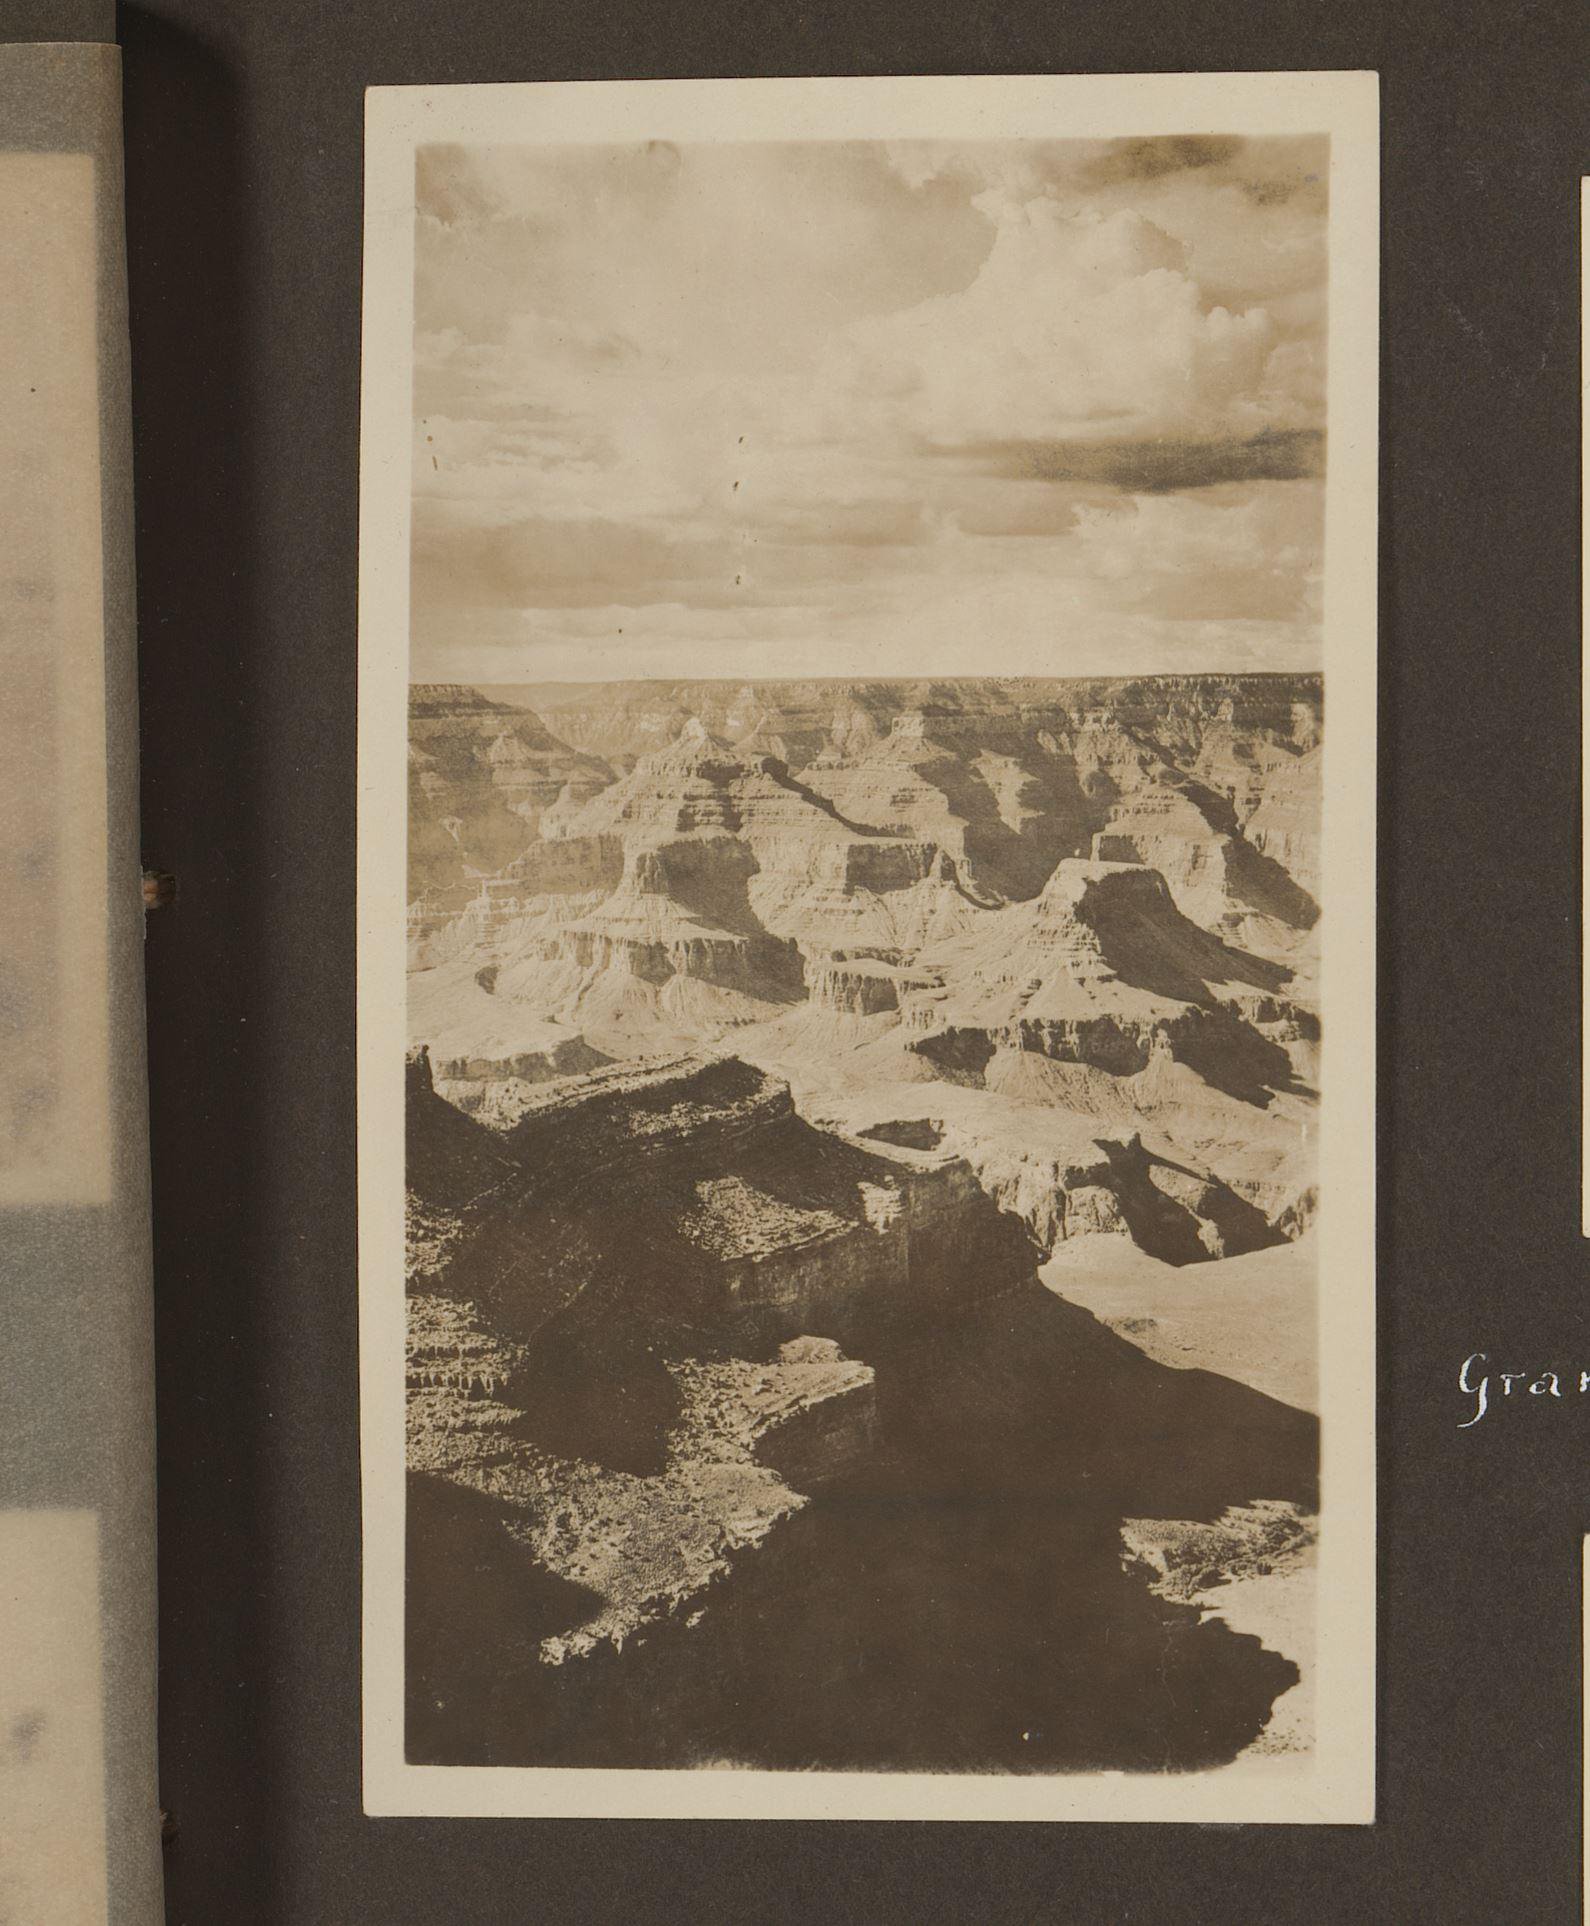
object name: album leaf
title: Gezicht op de Grand Canyon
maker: Anonymous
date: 1928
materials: photographic support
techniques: gelatin silver print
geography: grand canyon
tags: ravine, chasm, abyss, canyon, mountains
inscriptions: annotation: ‘Grand Canyon’